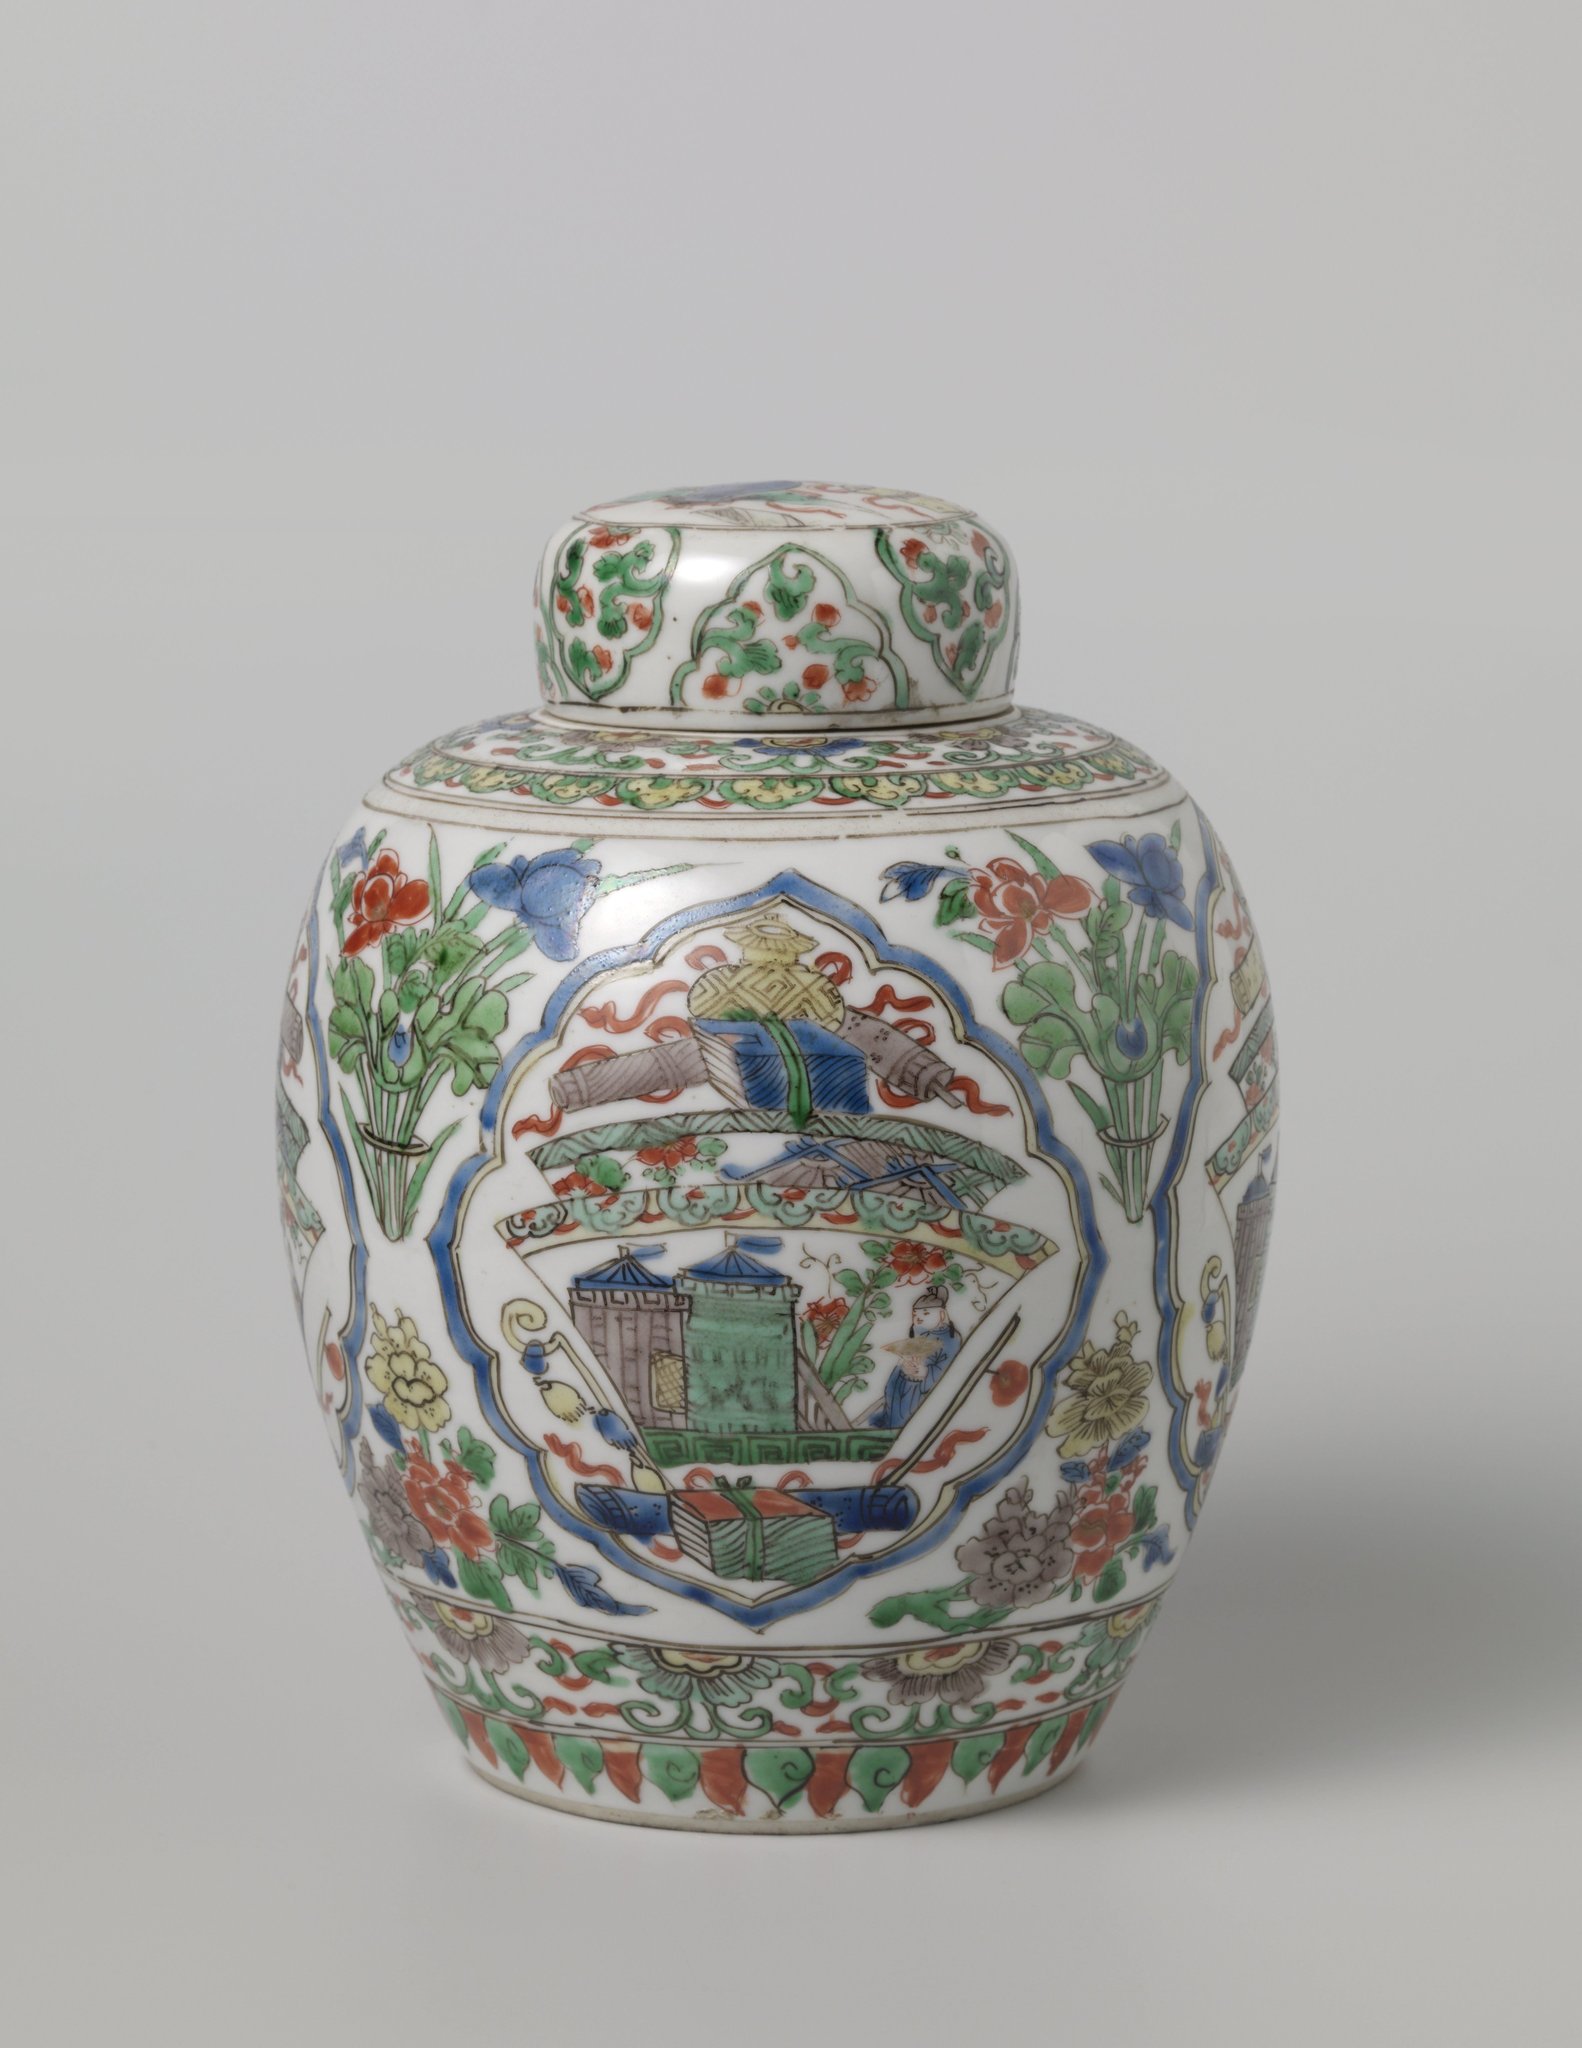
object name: lid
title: Covered, ovoid jar with antiquities and flower sprays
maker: Anonymous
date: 1700-1724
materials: cobalt, glaze, gold, paint, porcelain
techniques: firing, gilding, turning, vitrification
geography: china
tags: verzamelaar, jurist, jean theodore royer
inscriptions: mark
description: Deksel van eivormige dekselpot van porselein, beschilderd in onderglazuur blauw en op het glazuur blauw, rood, groen, geel, auberine, zwart en goud. Op de deksel gelobde cartouches met bladvoluten en een medaillon met antiquiteiten. Gemerkt op de onderzijde met een ruit in groen en zwart email in een dubbele cirkel. Famille verte.